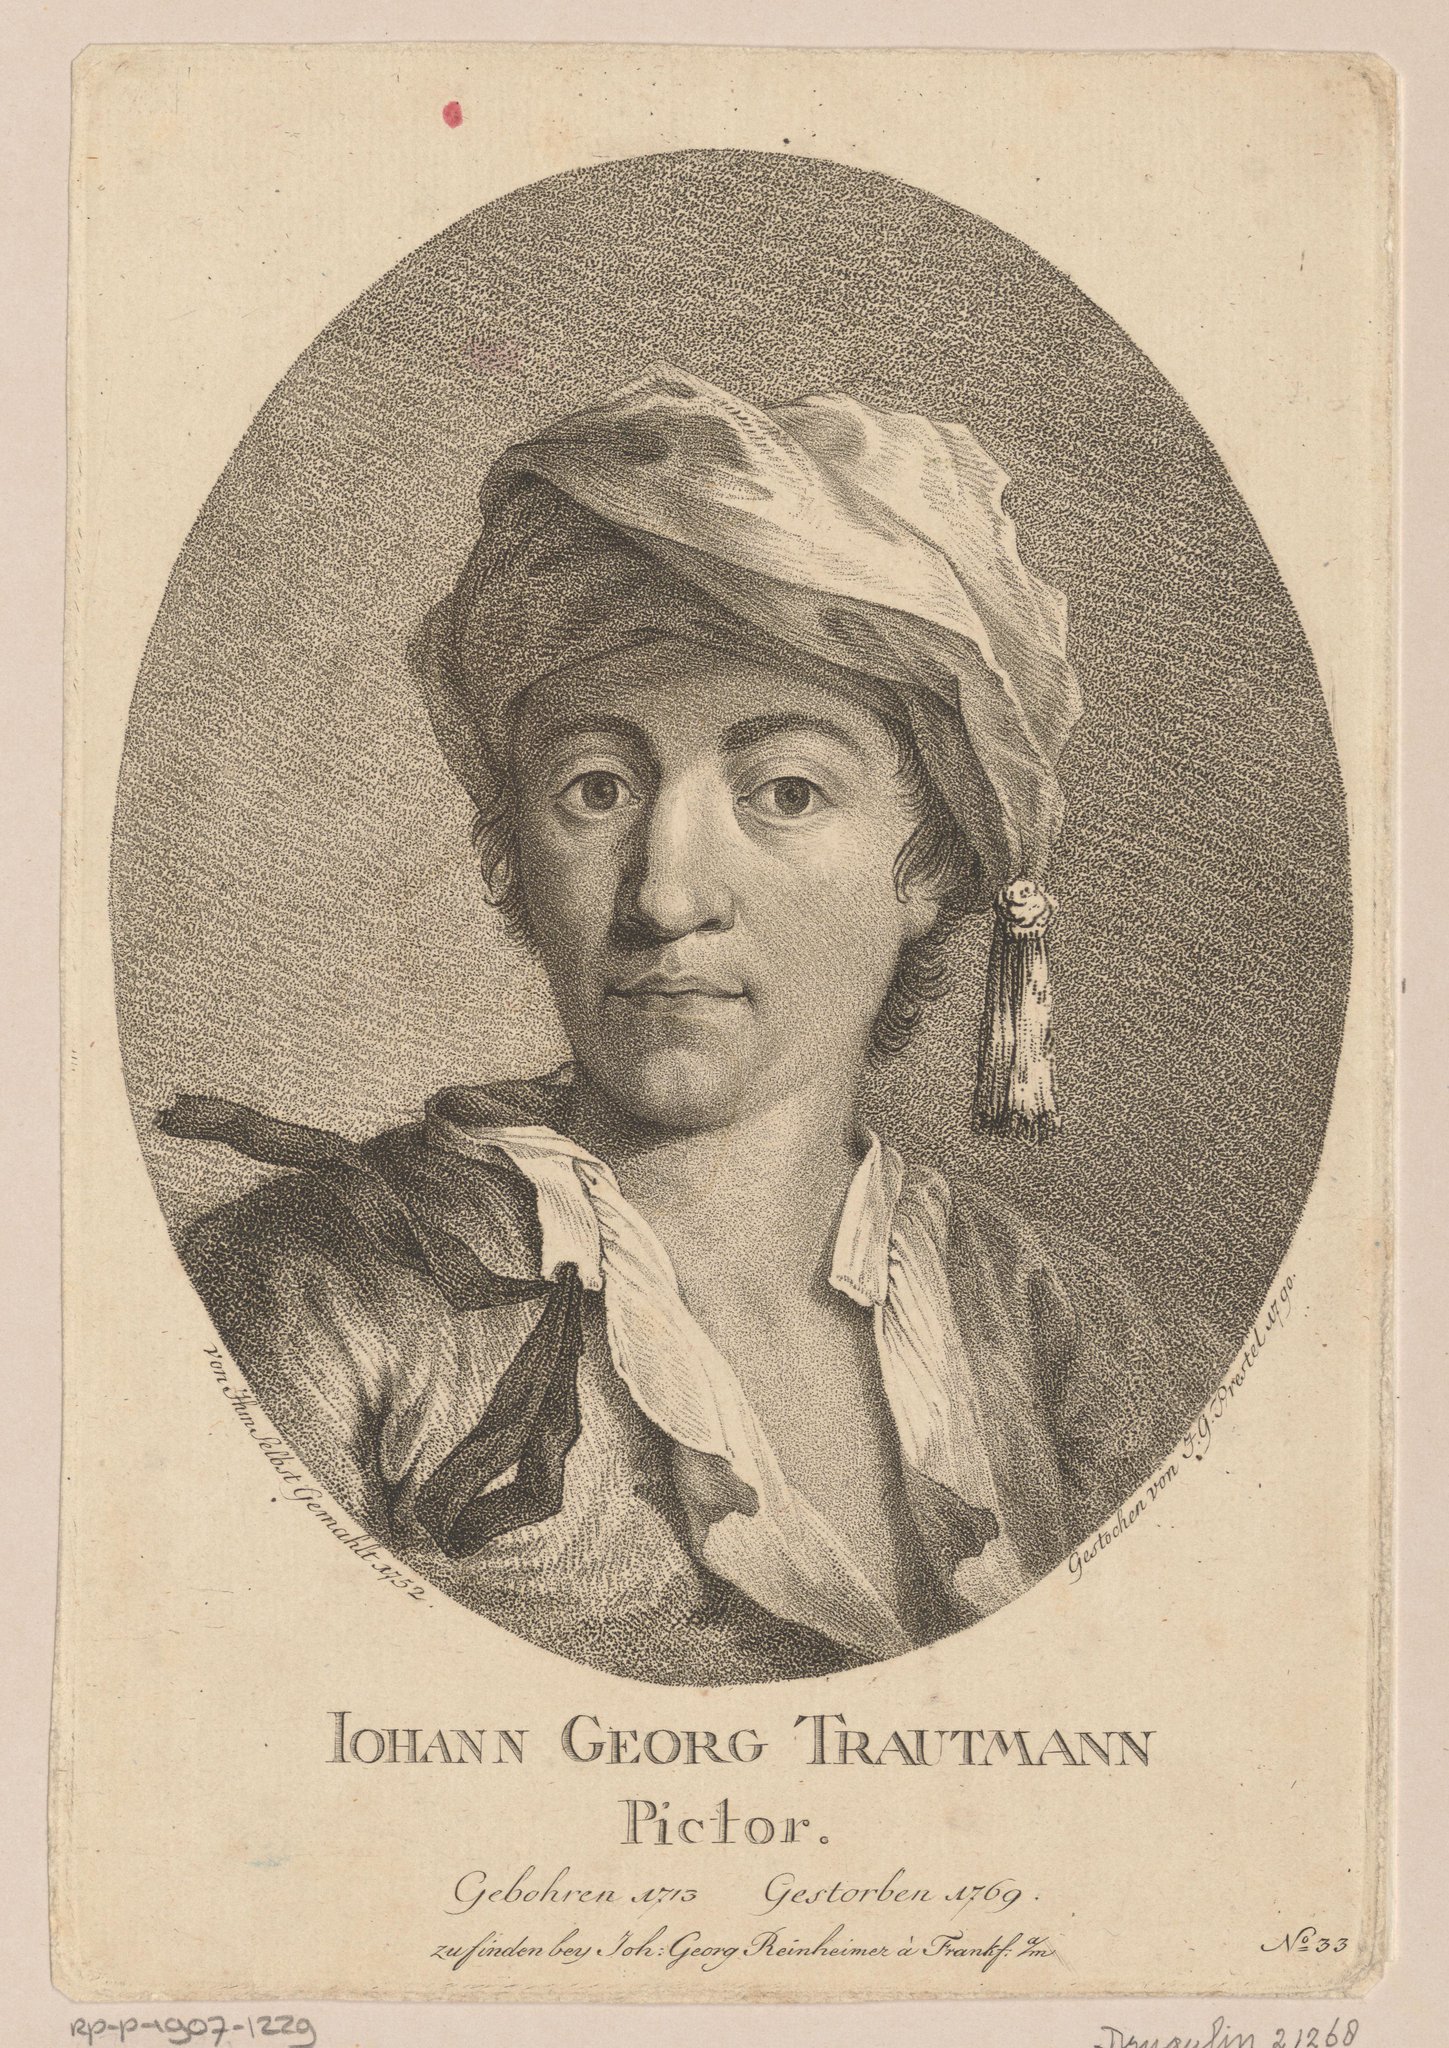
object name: print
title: Portret van Johann Georg Trautmann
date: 1790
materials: paper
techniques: etching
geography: germany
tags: painter, draughtsman, johann georg trautmann, historical persons, portrait, self-portrait of painter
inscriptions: collector's mark: Lugt 2228